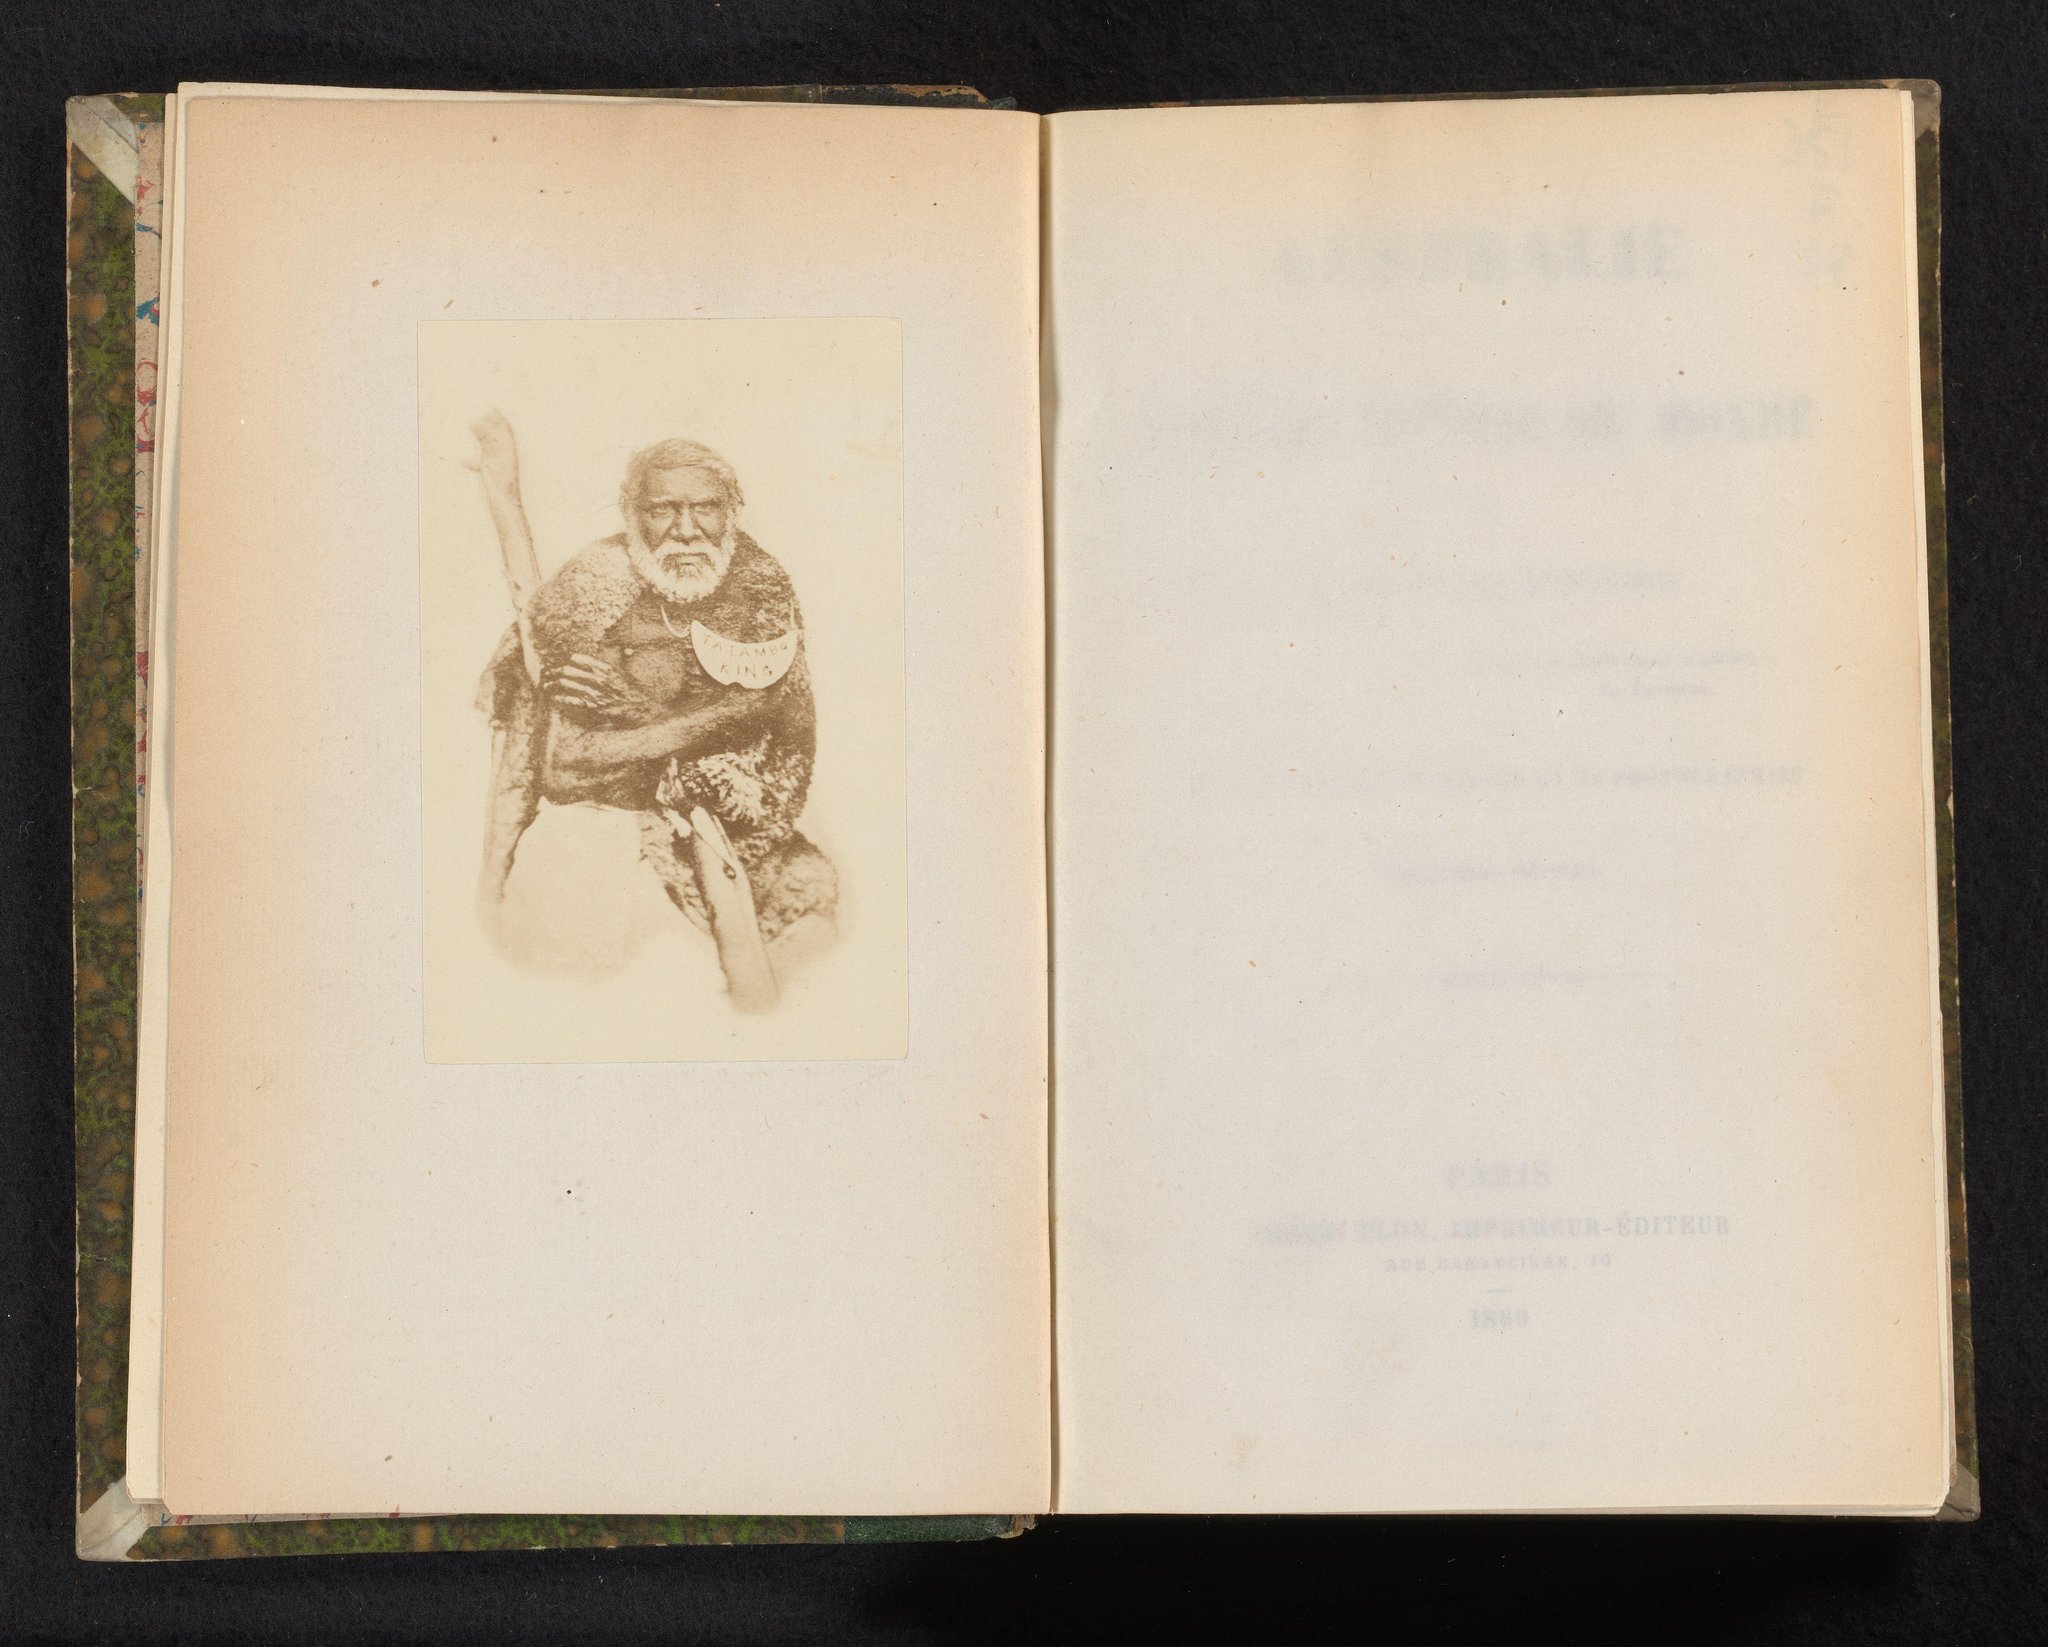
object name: page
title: Portret van Tatambo King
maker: Anonymous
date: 1864-1869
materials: paper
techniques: albumen print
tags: historical persons